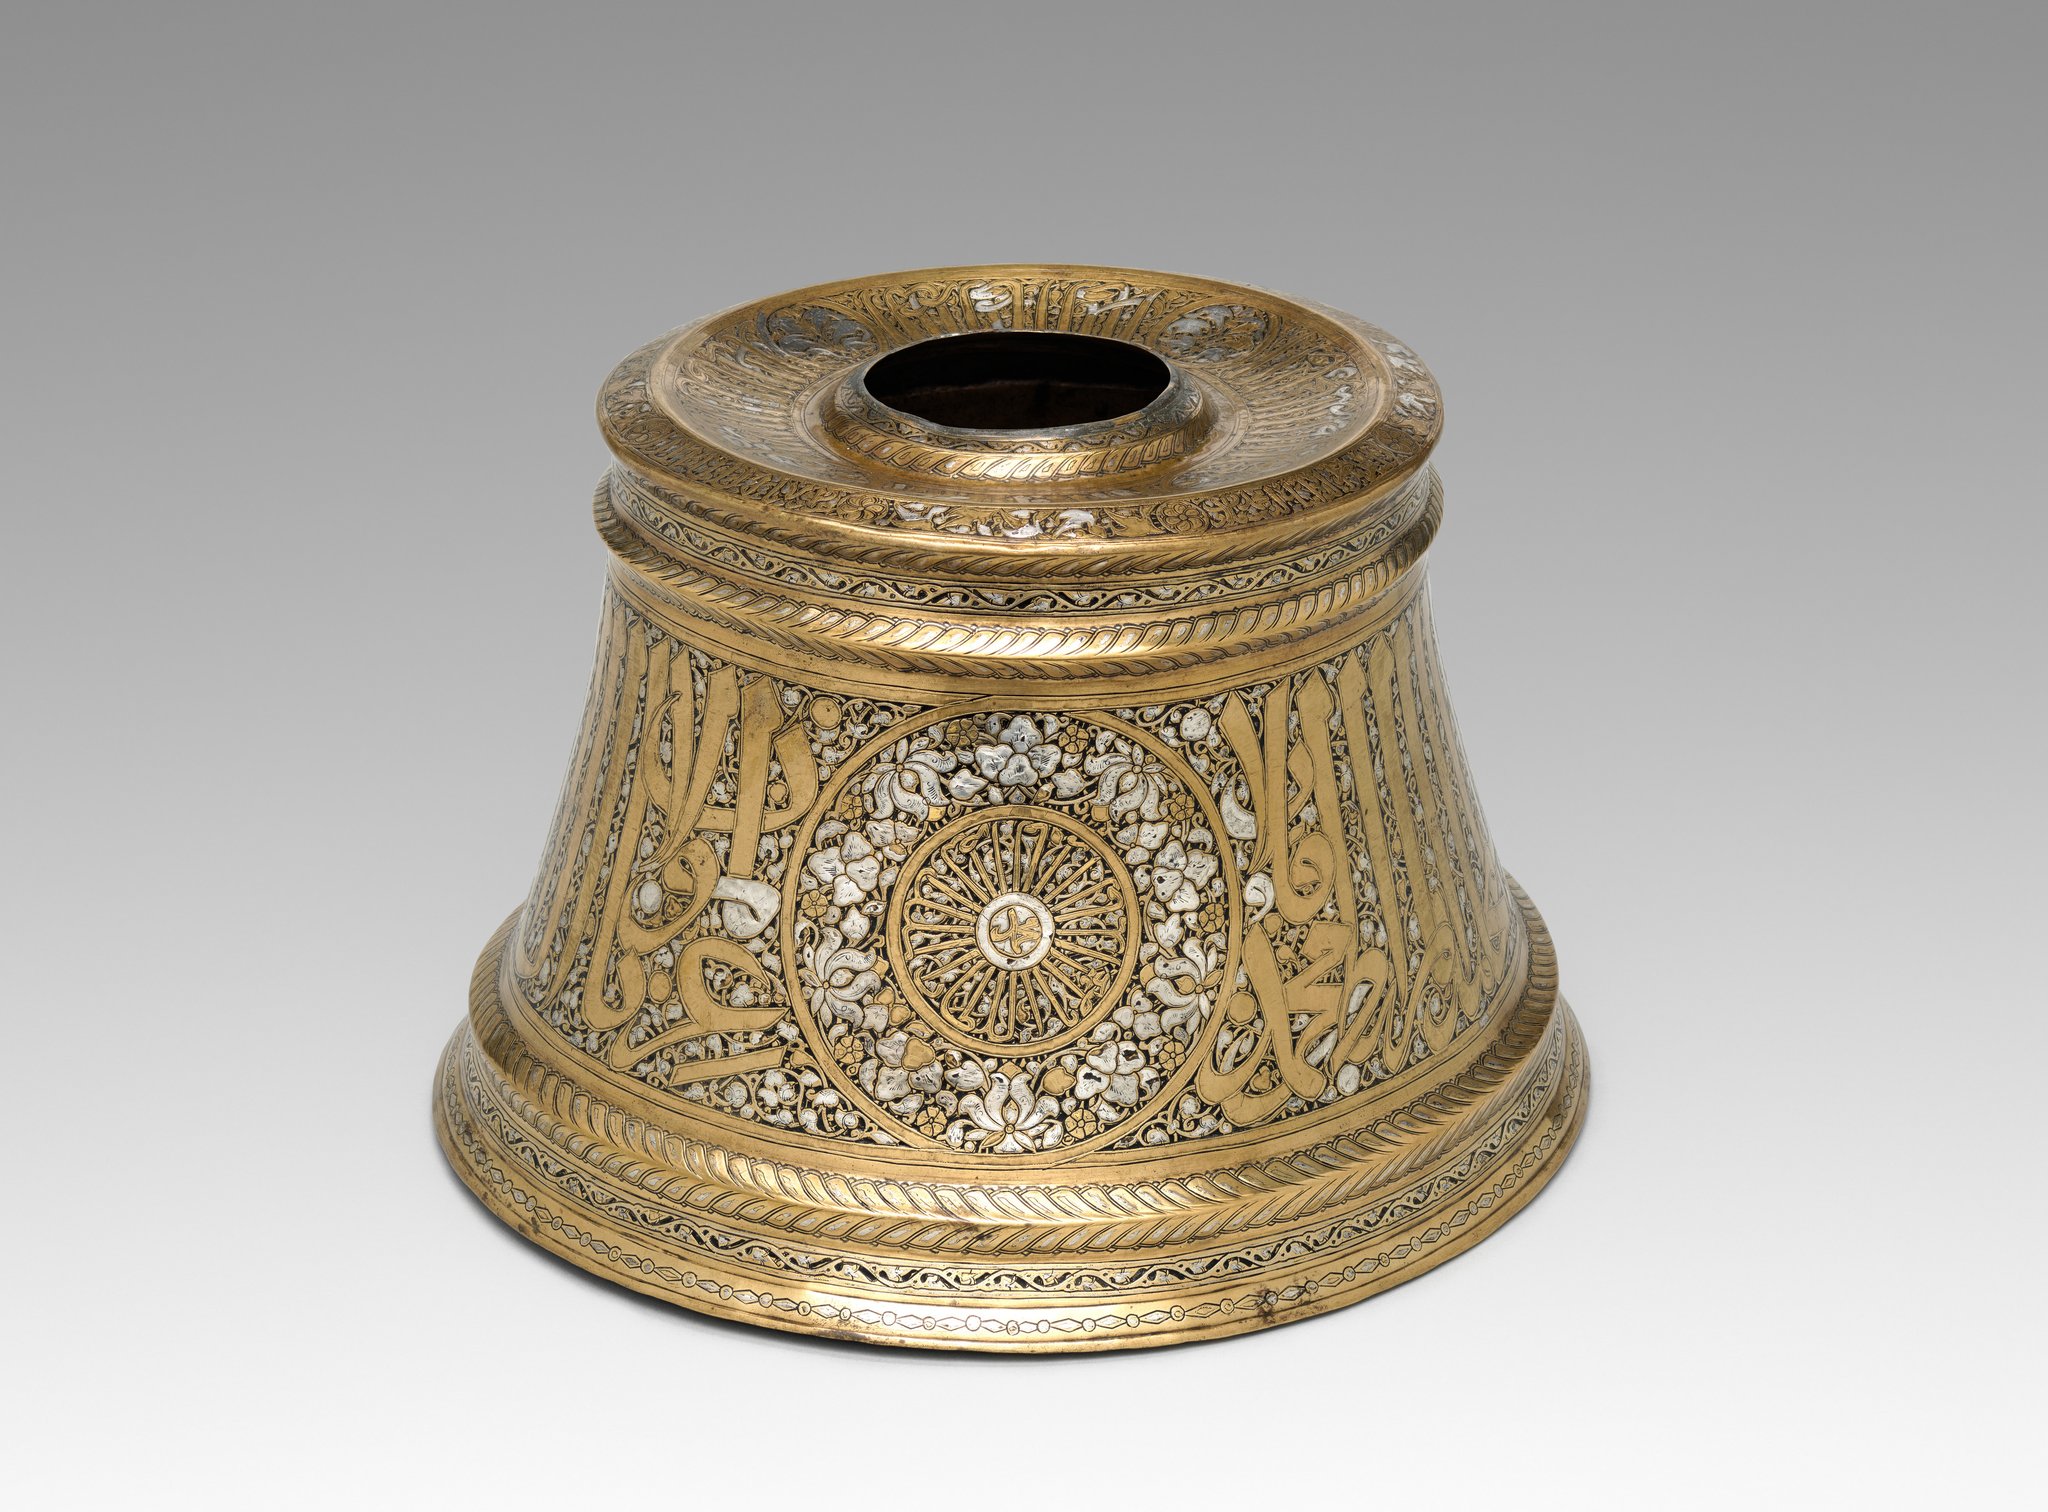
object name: candlestick base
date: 1301-1350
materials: brass, silver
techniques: inlay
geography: egypt